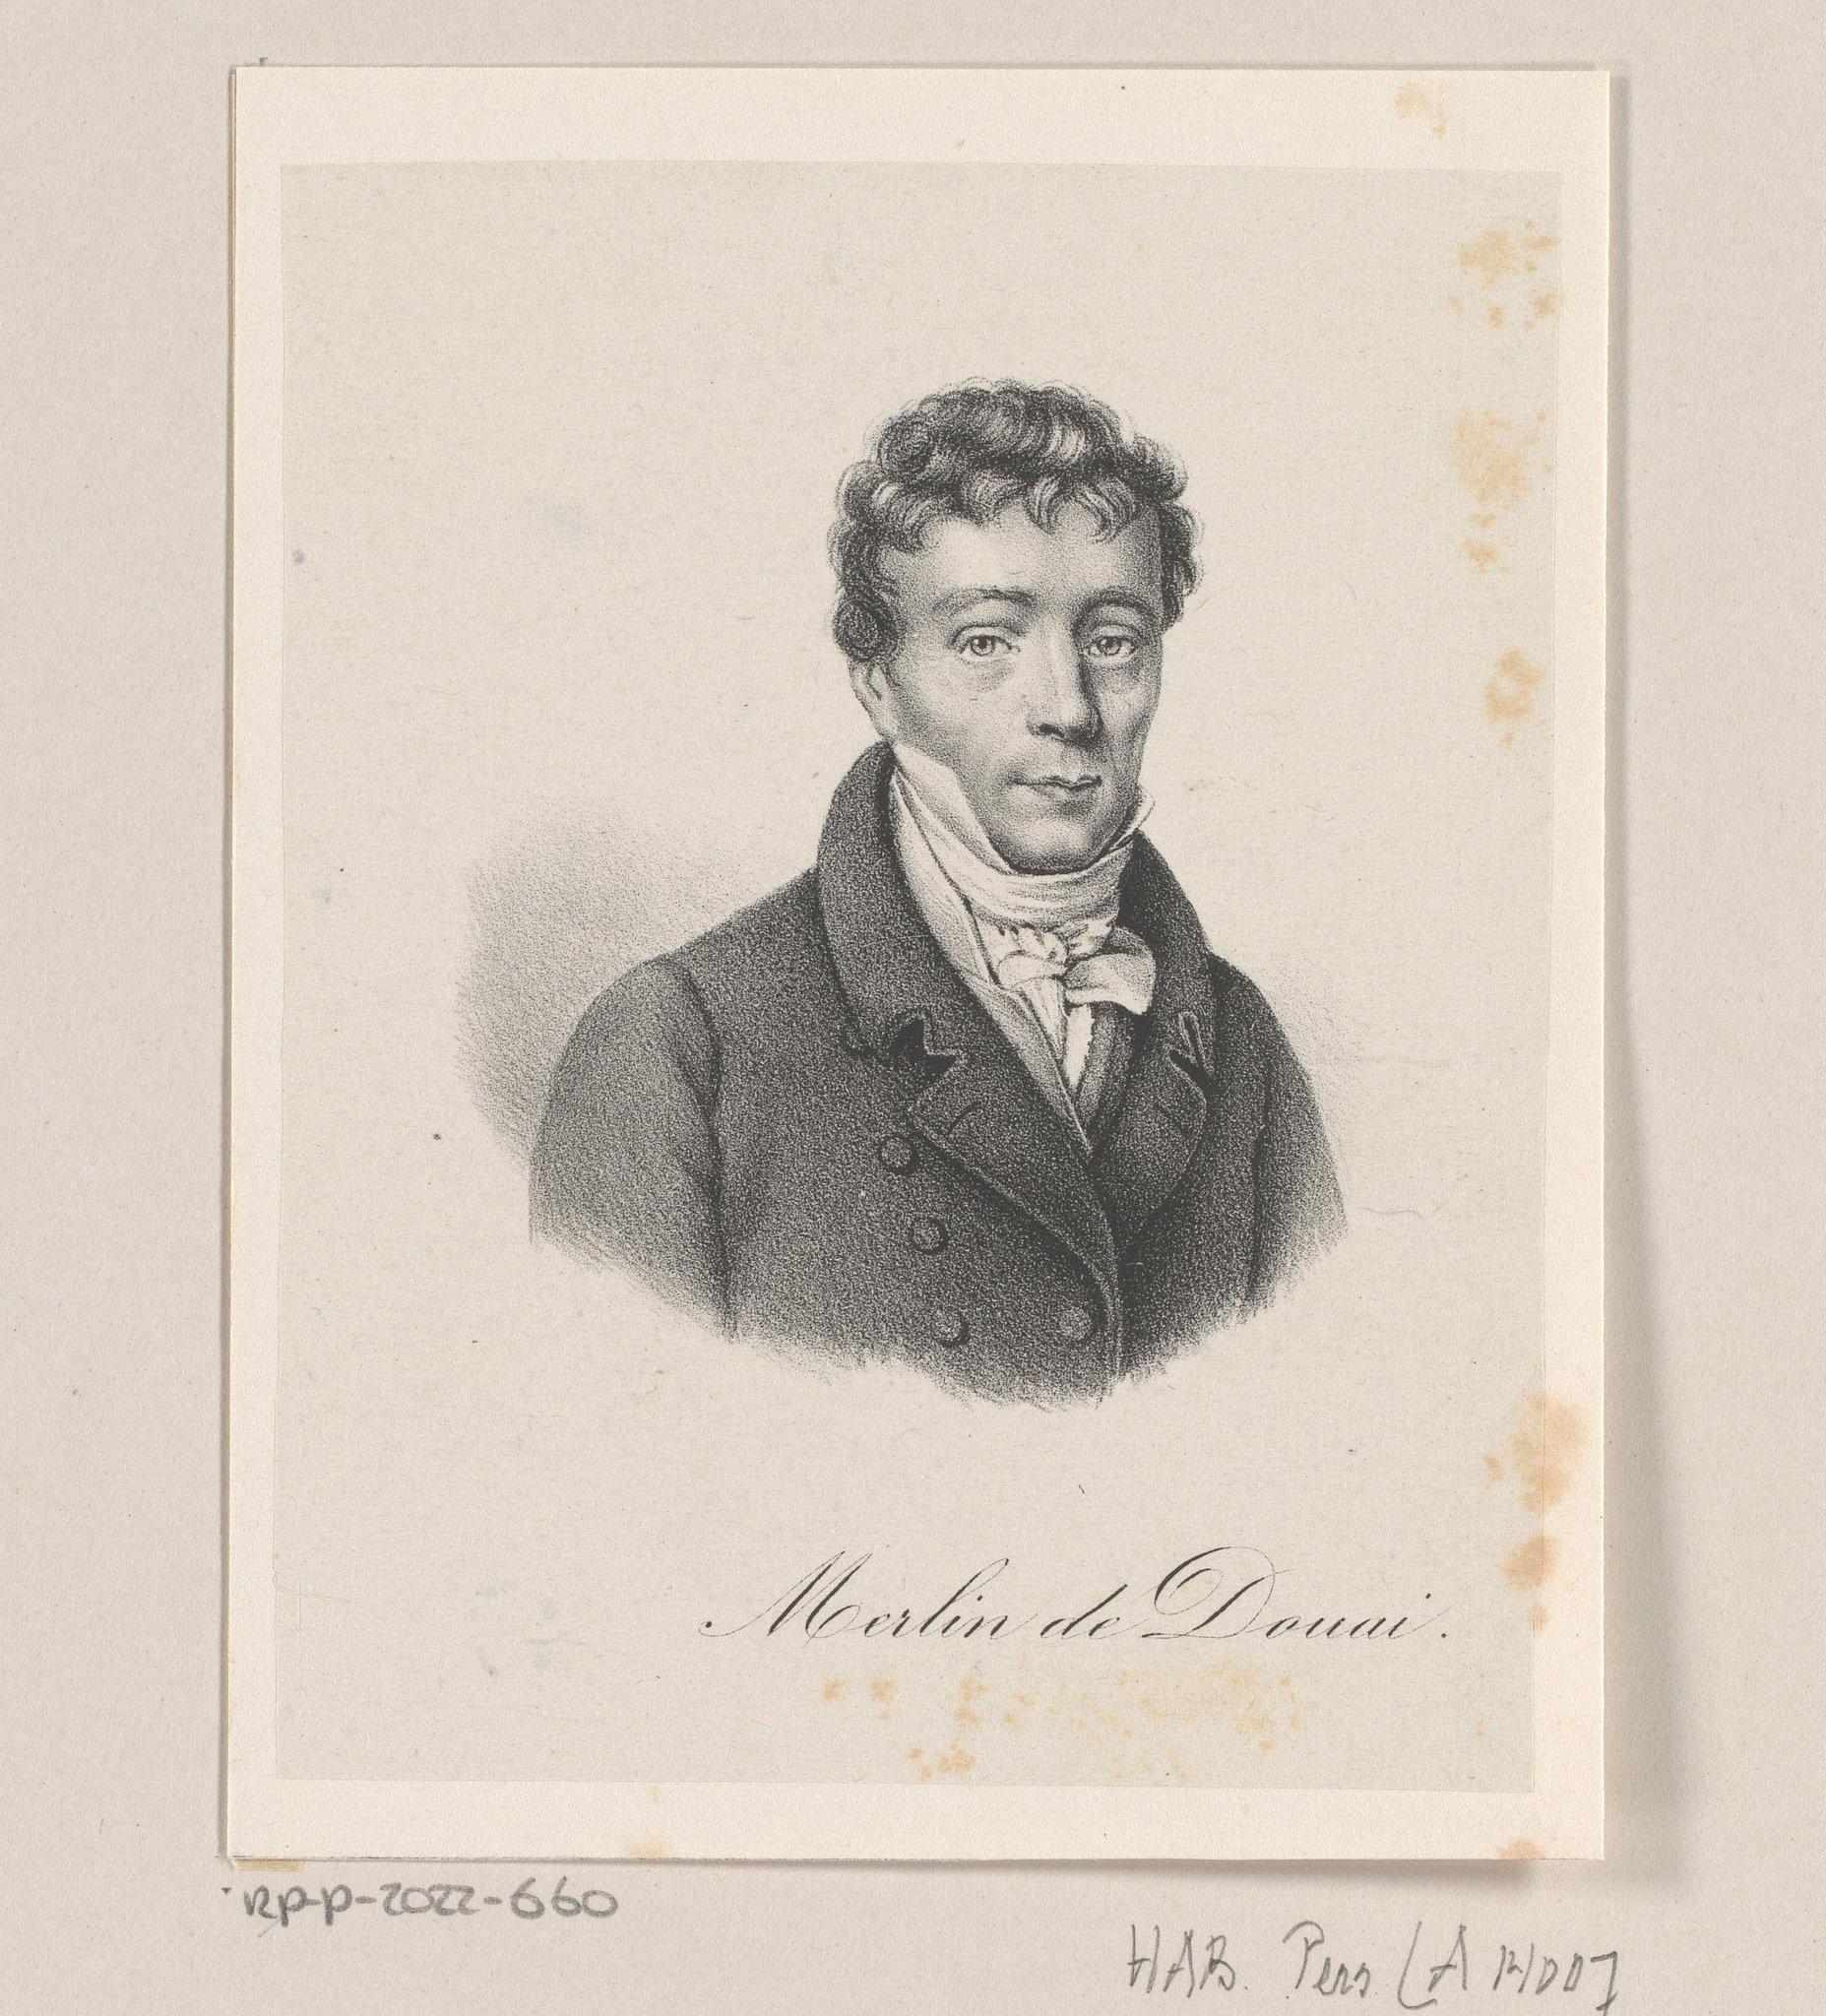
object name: print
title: Portret van Philippe-Antoine Merlin de Douai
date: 1818-1842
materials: paper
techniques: lithograph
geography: paris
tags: paris, historical persons